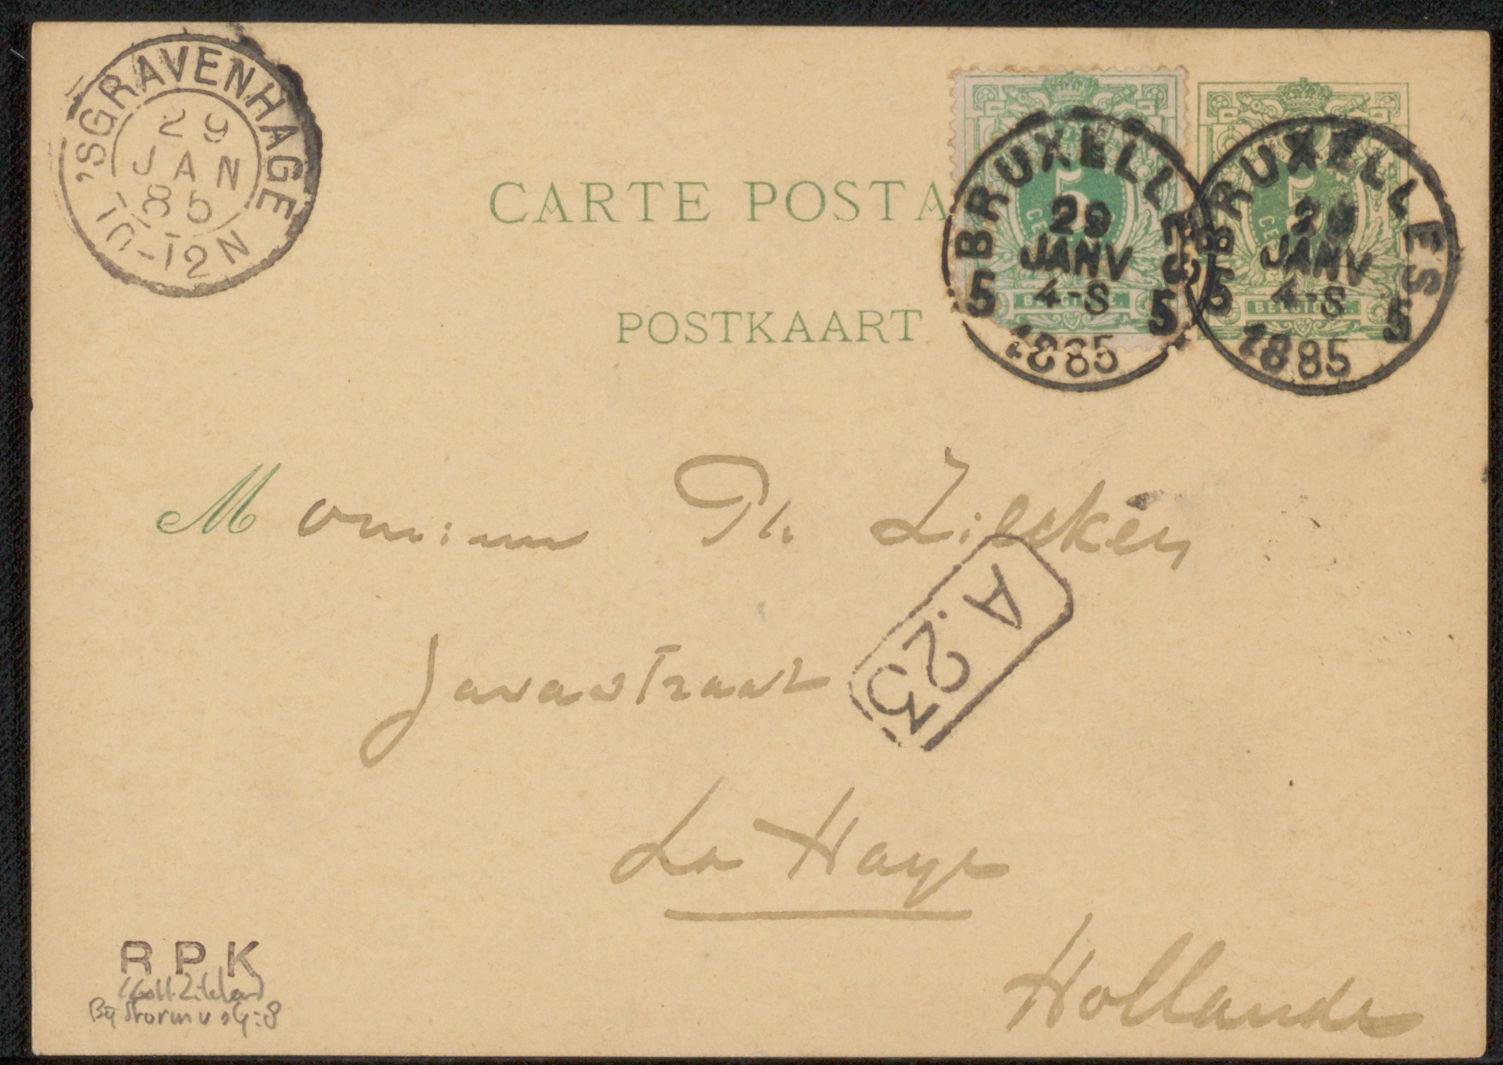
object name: letter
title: Brief aan Philip Zilcken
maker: carel nicolaas storm van s-gravesande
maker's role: draughtsman, print maker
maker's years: 1841-1924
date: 1851-1924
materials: ink, paper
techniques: pen, writing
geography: brussels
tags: frederick keppel, the hague, painter, draughtsman, philip zilcken, paris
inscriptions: watermark, collector's mark: ‘RPK’